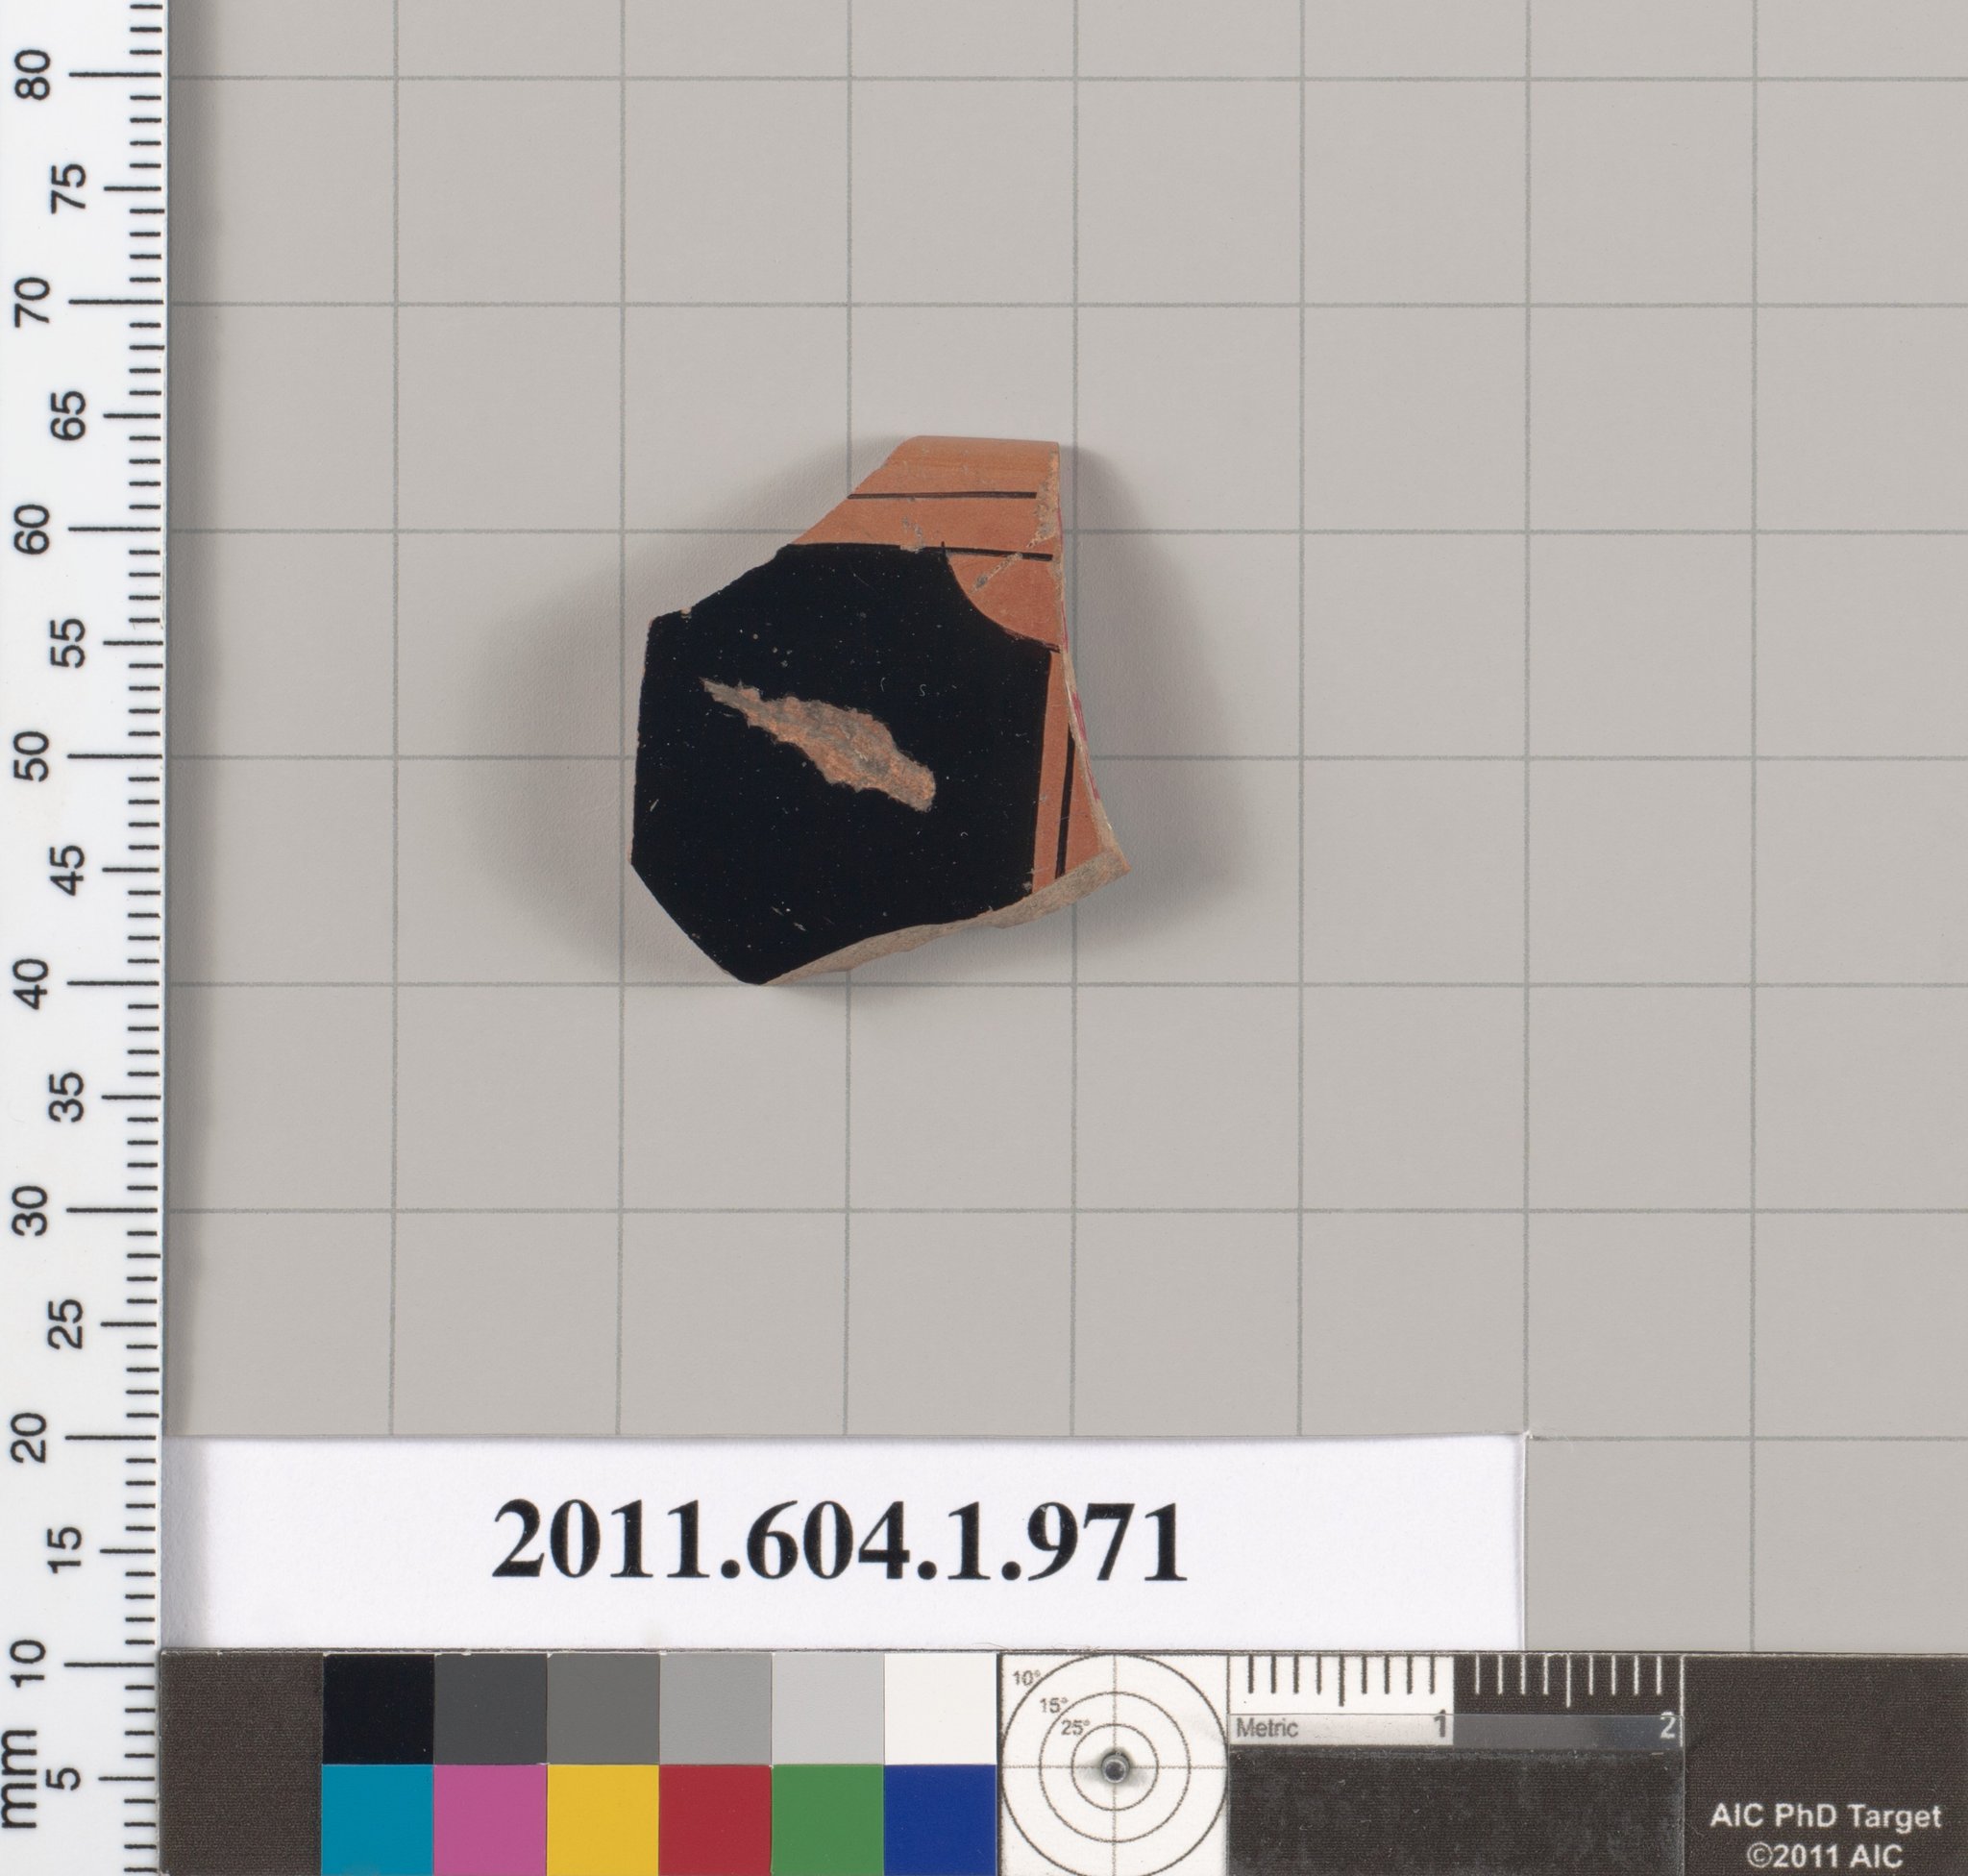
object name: kylix fragment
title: Terracotta rim fragment of a kylix (drinking cup)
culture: greek, attic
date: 490-480 BCE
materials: terracotta